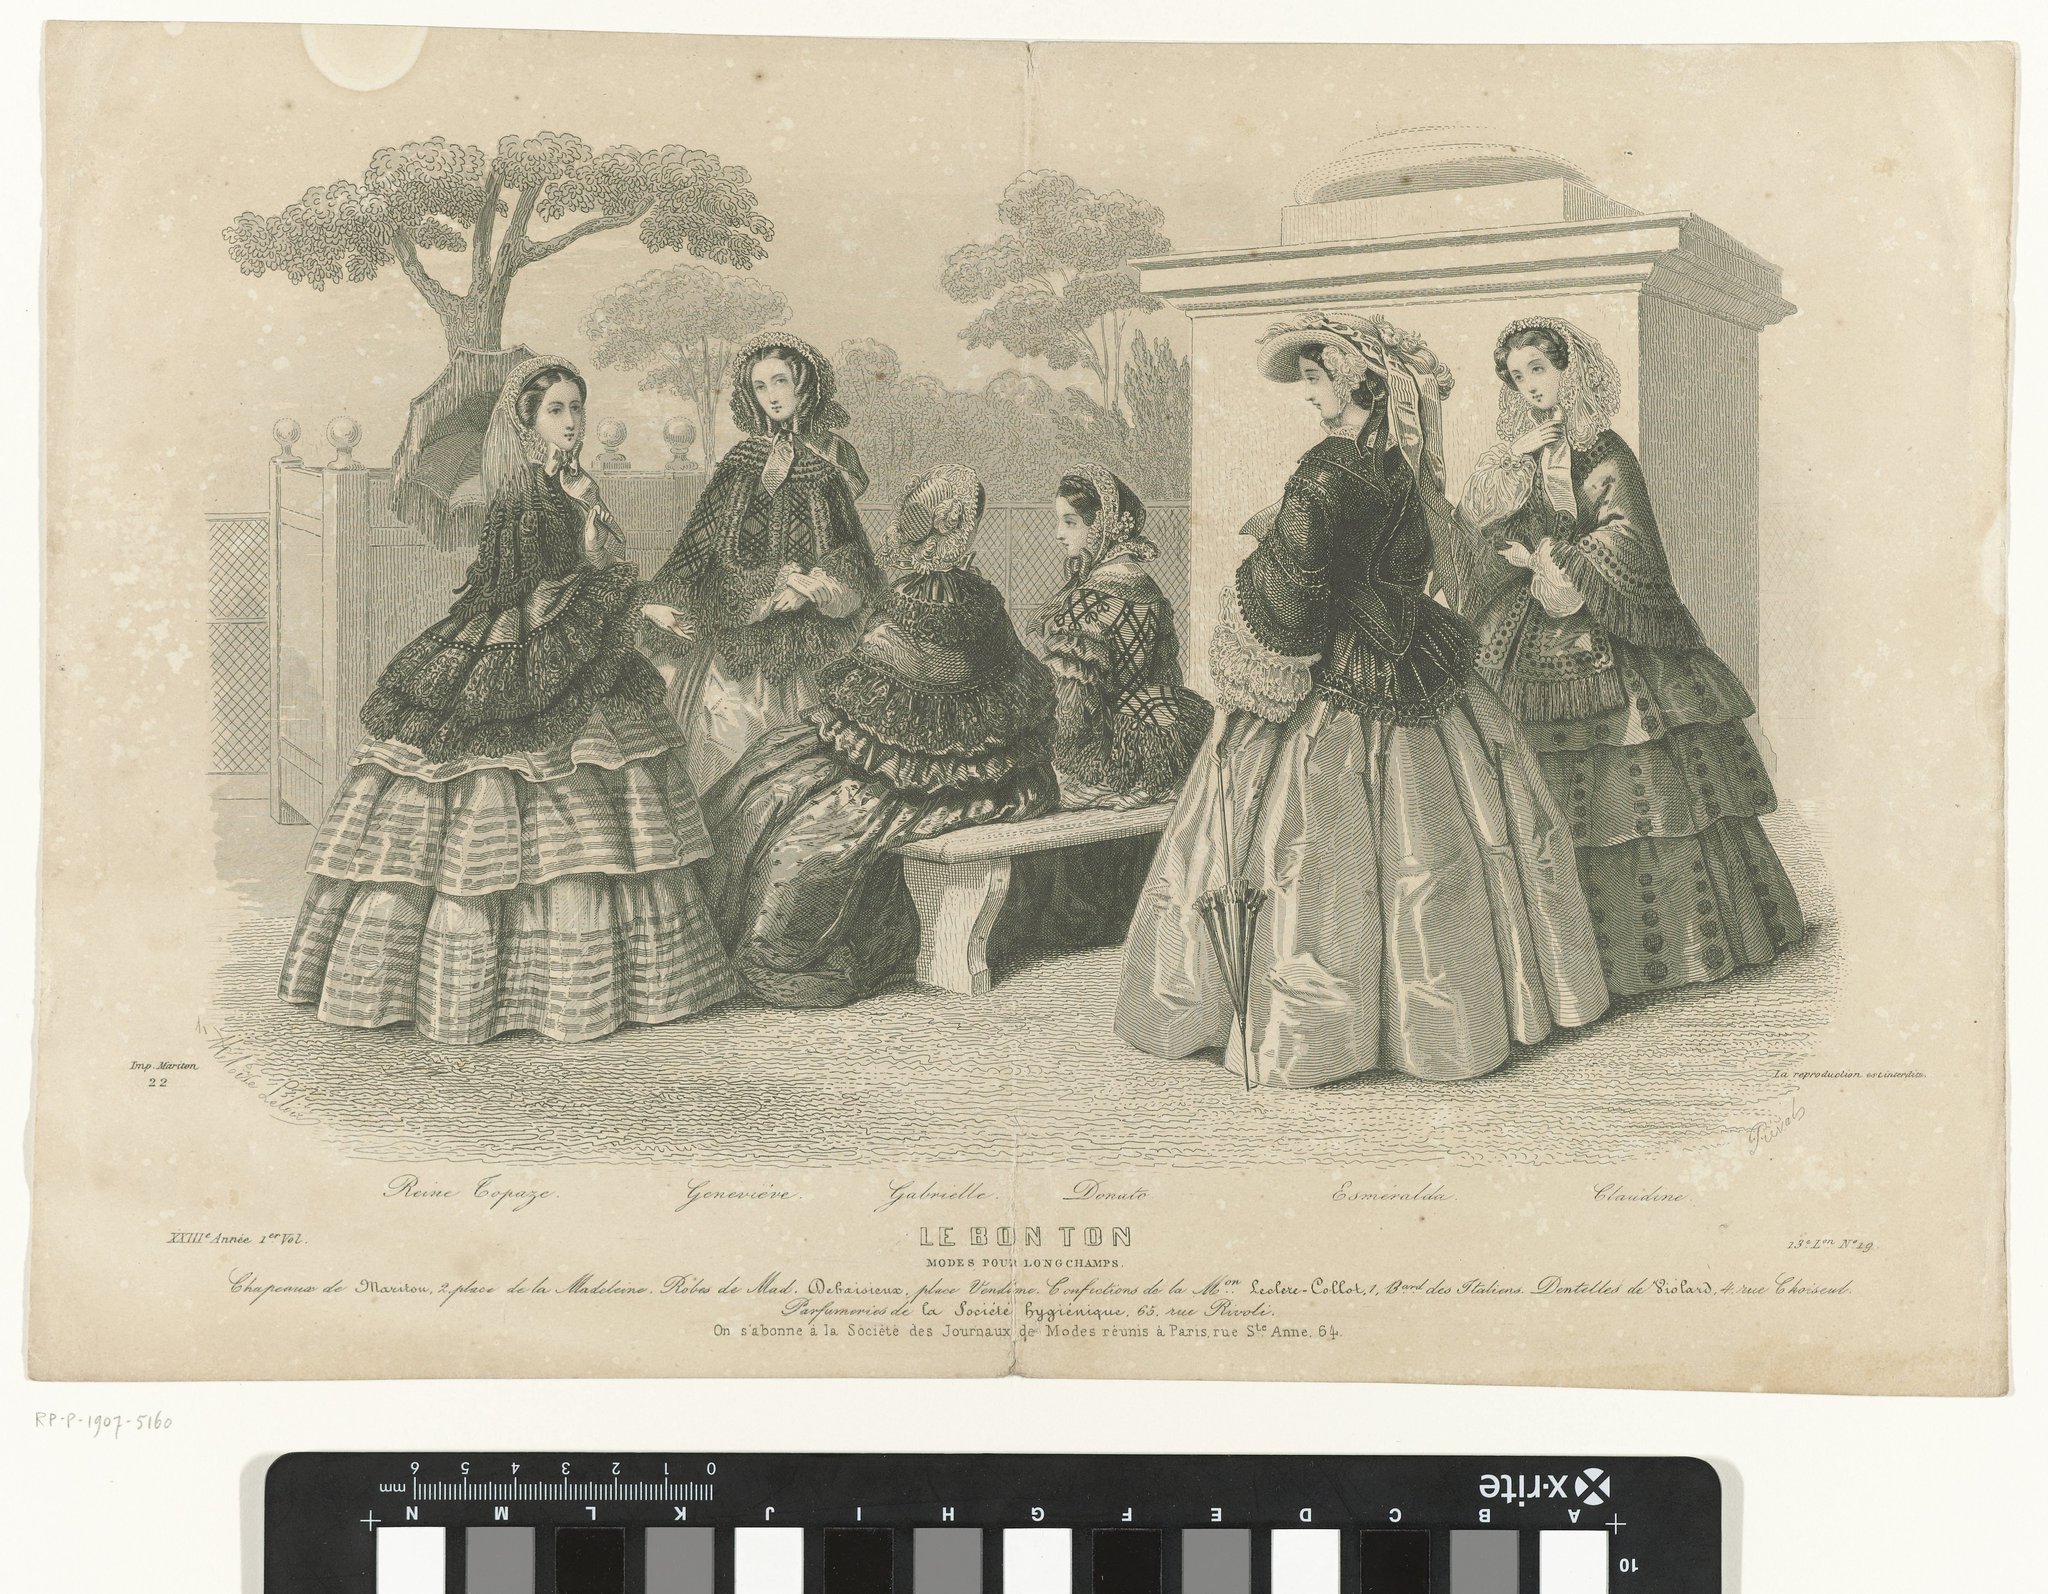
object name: fashion print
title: Le Bon Ton, ca. 1854, 23e Année, 1er Vol,13e L.on, No. 19: Modes pour Longchamps...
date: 1854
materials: paper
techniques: etching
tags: coat (short coat) (+ women's clothes), fashion plates, head-gear: hat (+ women's clothes), skirt (+ women's clothes), public gardens, park, parasol, sunshade (+ women's clothes)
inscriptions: caption: ‘On s'abonne à la Siciété des Journeaux de Modes réunis à Paris, rue St. Anne 64’, title: ‘LE BON TON / MODES POUR LONGCHAMPS’, caption: ‘Chapeaux de Mariton, 2. place de la Madeleine, Robes de Md. Debaisieux, place Vendome, Confictions de la Mon. Leclerc-Collot, 1 B.ard. des Titaliens. Dentelles de Violard, 4 rue Choiseuil. Parfumerie de la Société hygiénique, 65 rue de Rivoli’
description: 'Modes pour Longchamps.' Zes vrouwen in een park,van links naar rechts: Reine Topaze, Genevieve, Gabrielle, Donate, Esmiralda, Claudine. Volgens het onderschrift: hoeden van Mariton. Japonnen van Mad. Debaisieux. Hieronder enkele regels reclametekst voor verschillende producten.